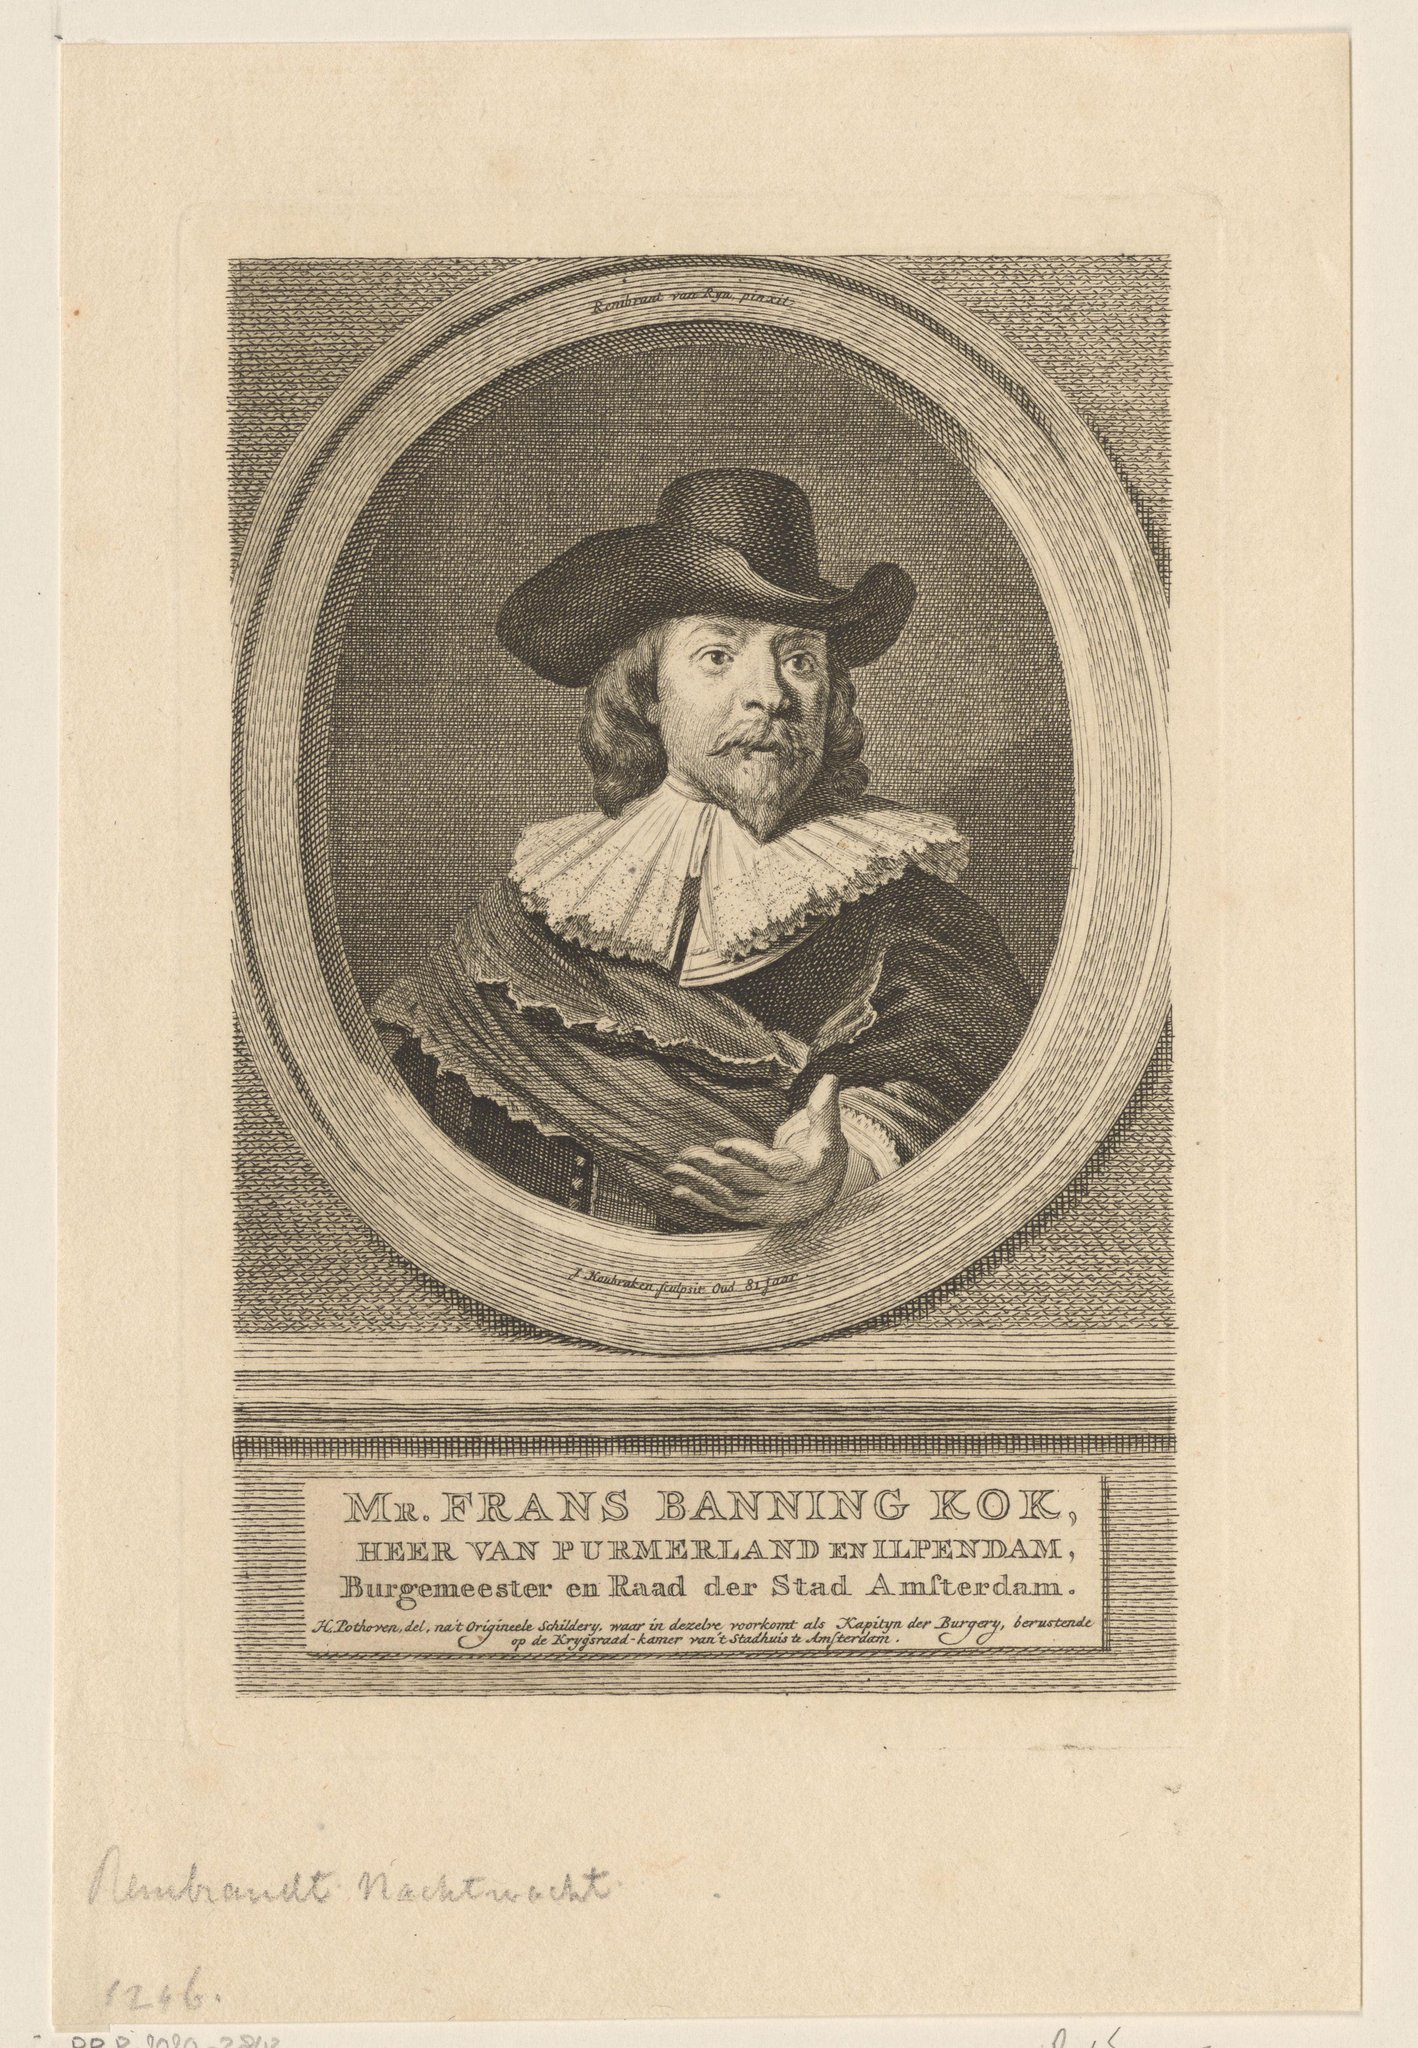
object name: print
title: Portret van Frans Banninck Cocq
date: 1749-1796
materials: paper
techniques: engraving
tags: mayor, frans banninck cocq, historical persons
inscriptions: collector's mark: Lugt 924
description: Prent mogelijk uit: Wagenaar, Jan. Vaderlandsche historie, vervattende de geschiedenissen der Vereenigde Nederlanden (…). 21 delen. Amsterdam: Isaak Tirion, 1749-1759. Ook verschenen in latere publicaties (1770, 1782, 1790-1796).